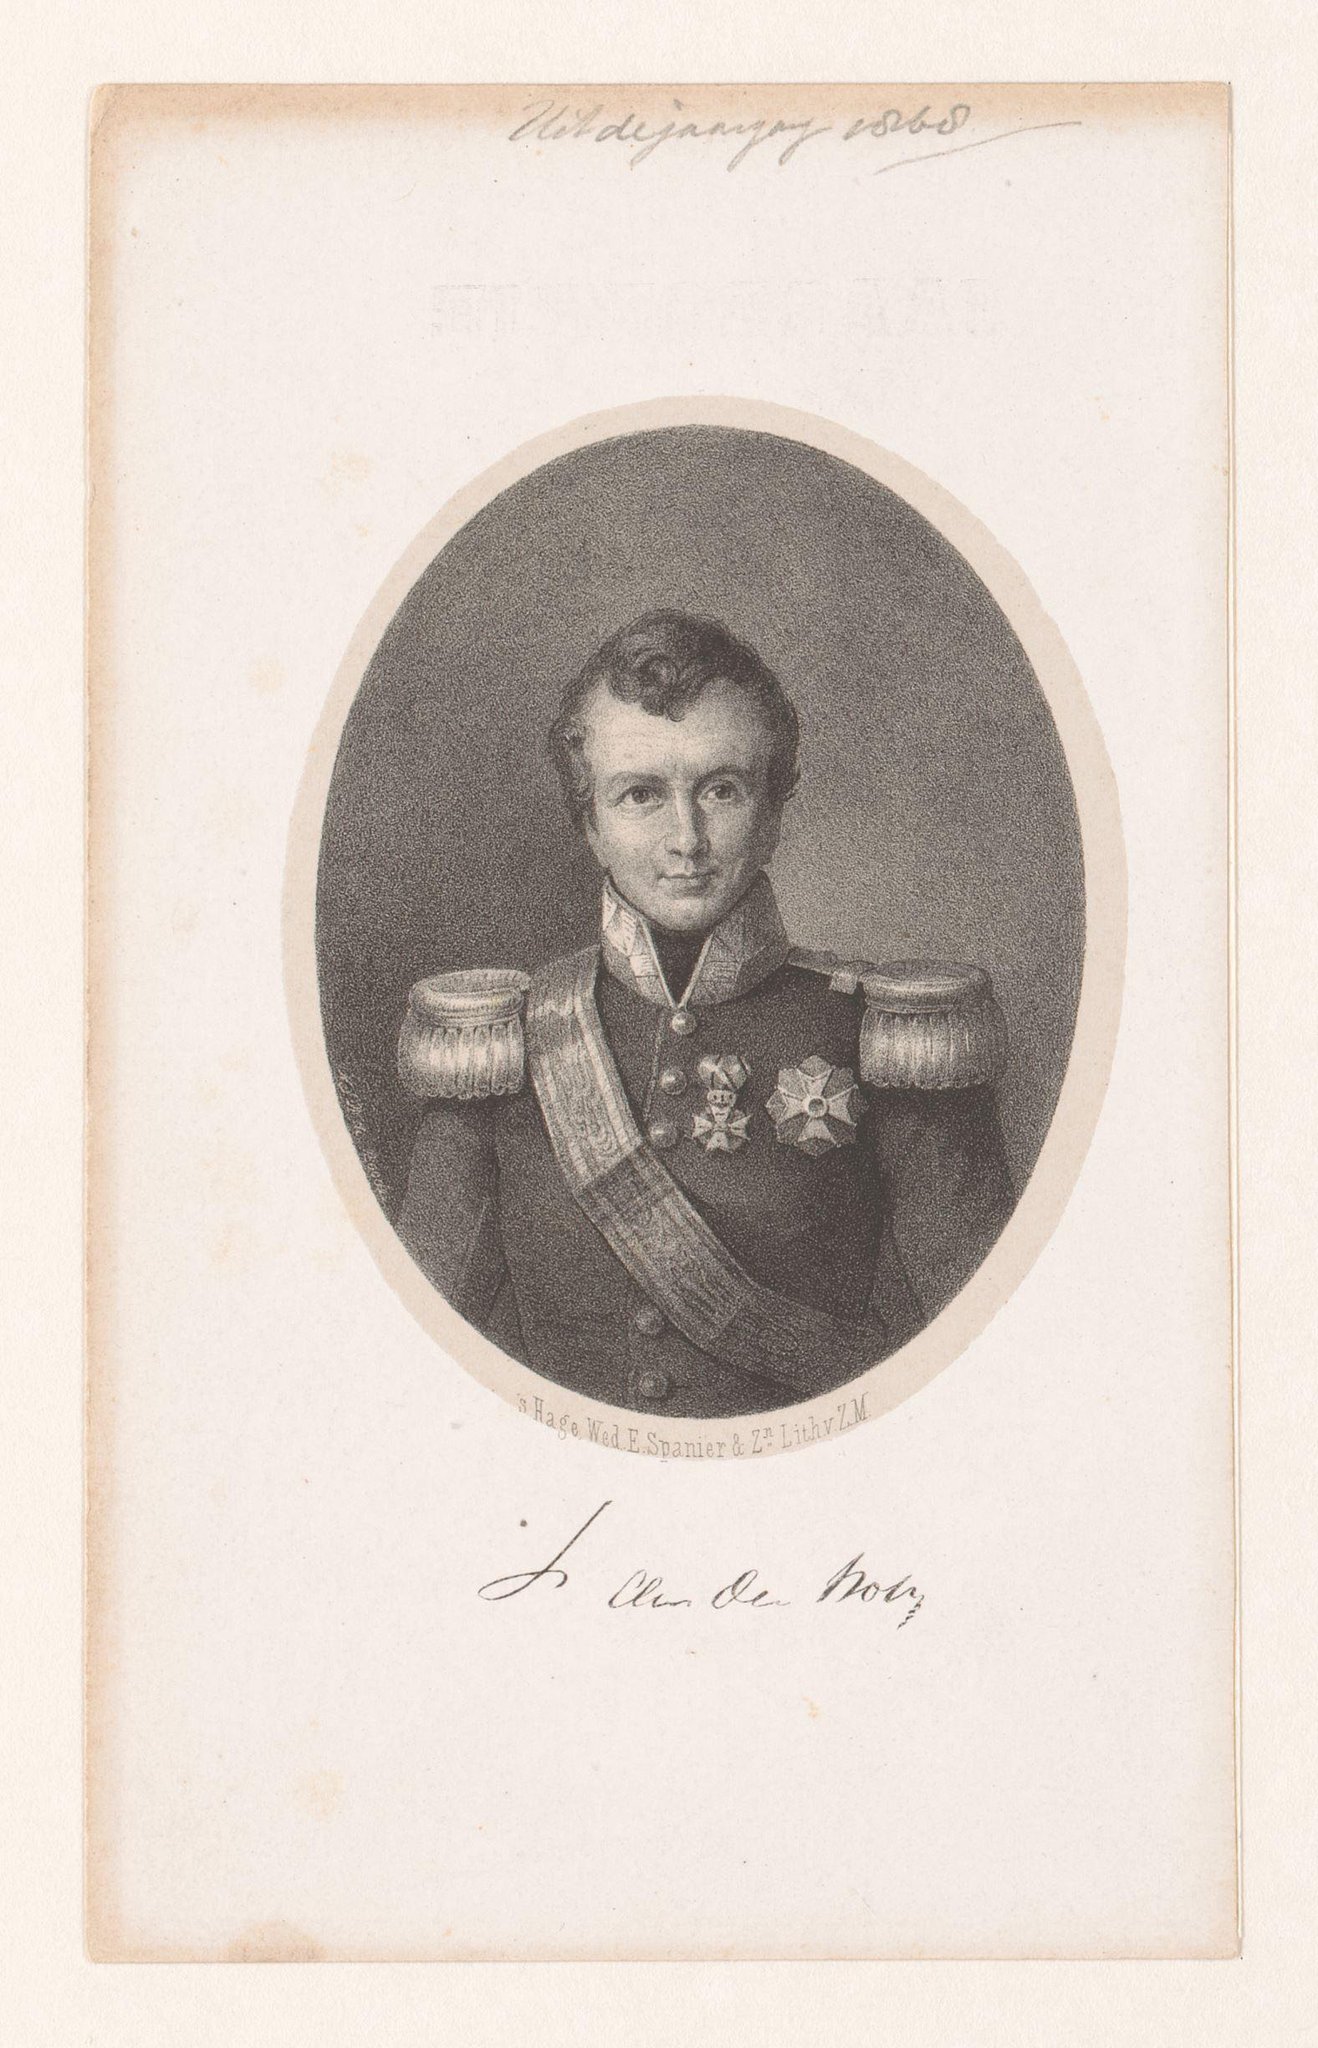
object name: print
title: Portret van onbekende man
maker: nicolaas johannes wilhelmus de roode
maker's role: draughtsman, print maker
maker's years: 1814-1884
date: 1863-1883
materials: paper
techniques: lithograph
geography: the hague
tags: anonymous historical person portrayed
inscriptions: collector's mark: Lugt 2228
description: Onder het portret de signatuur van de geportretteerde. (Slecht leesbaar).